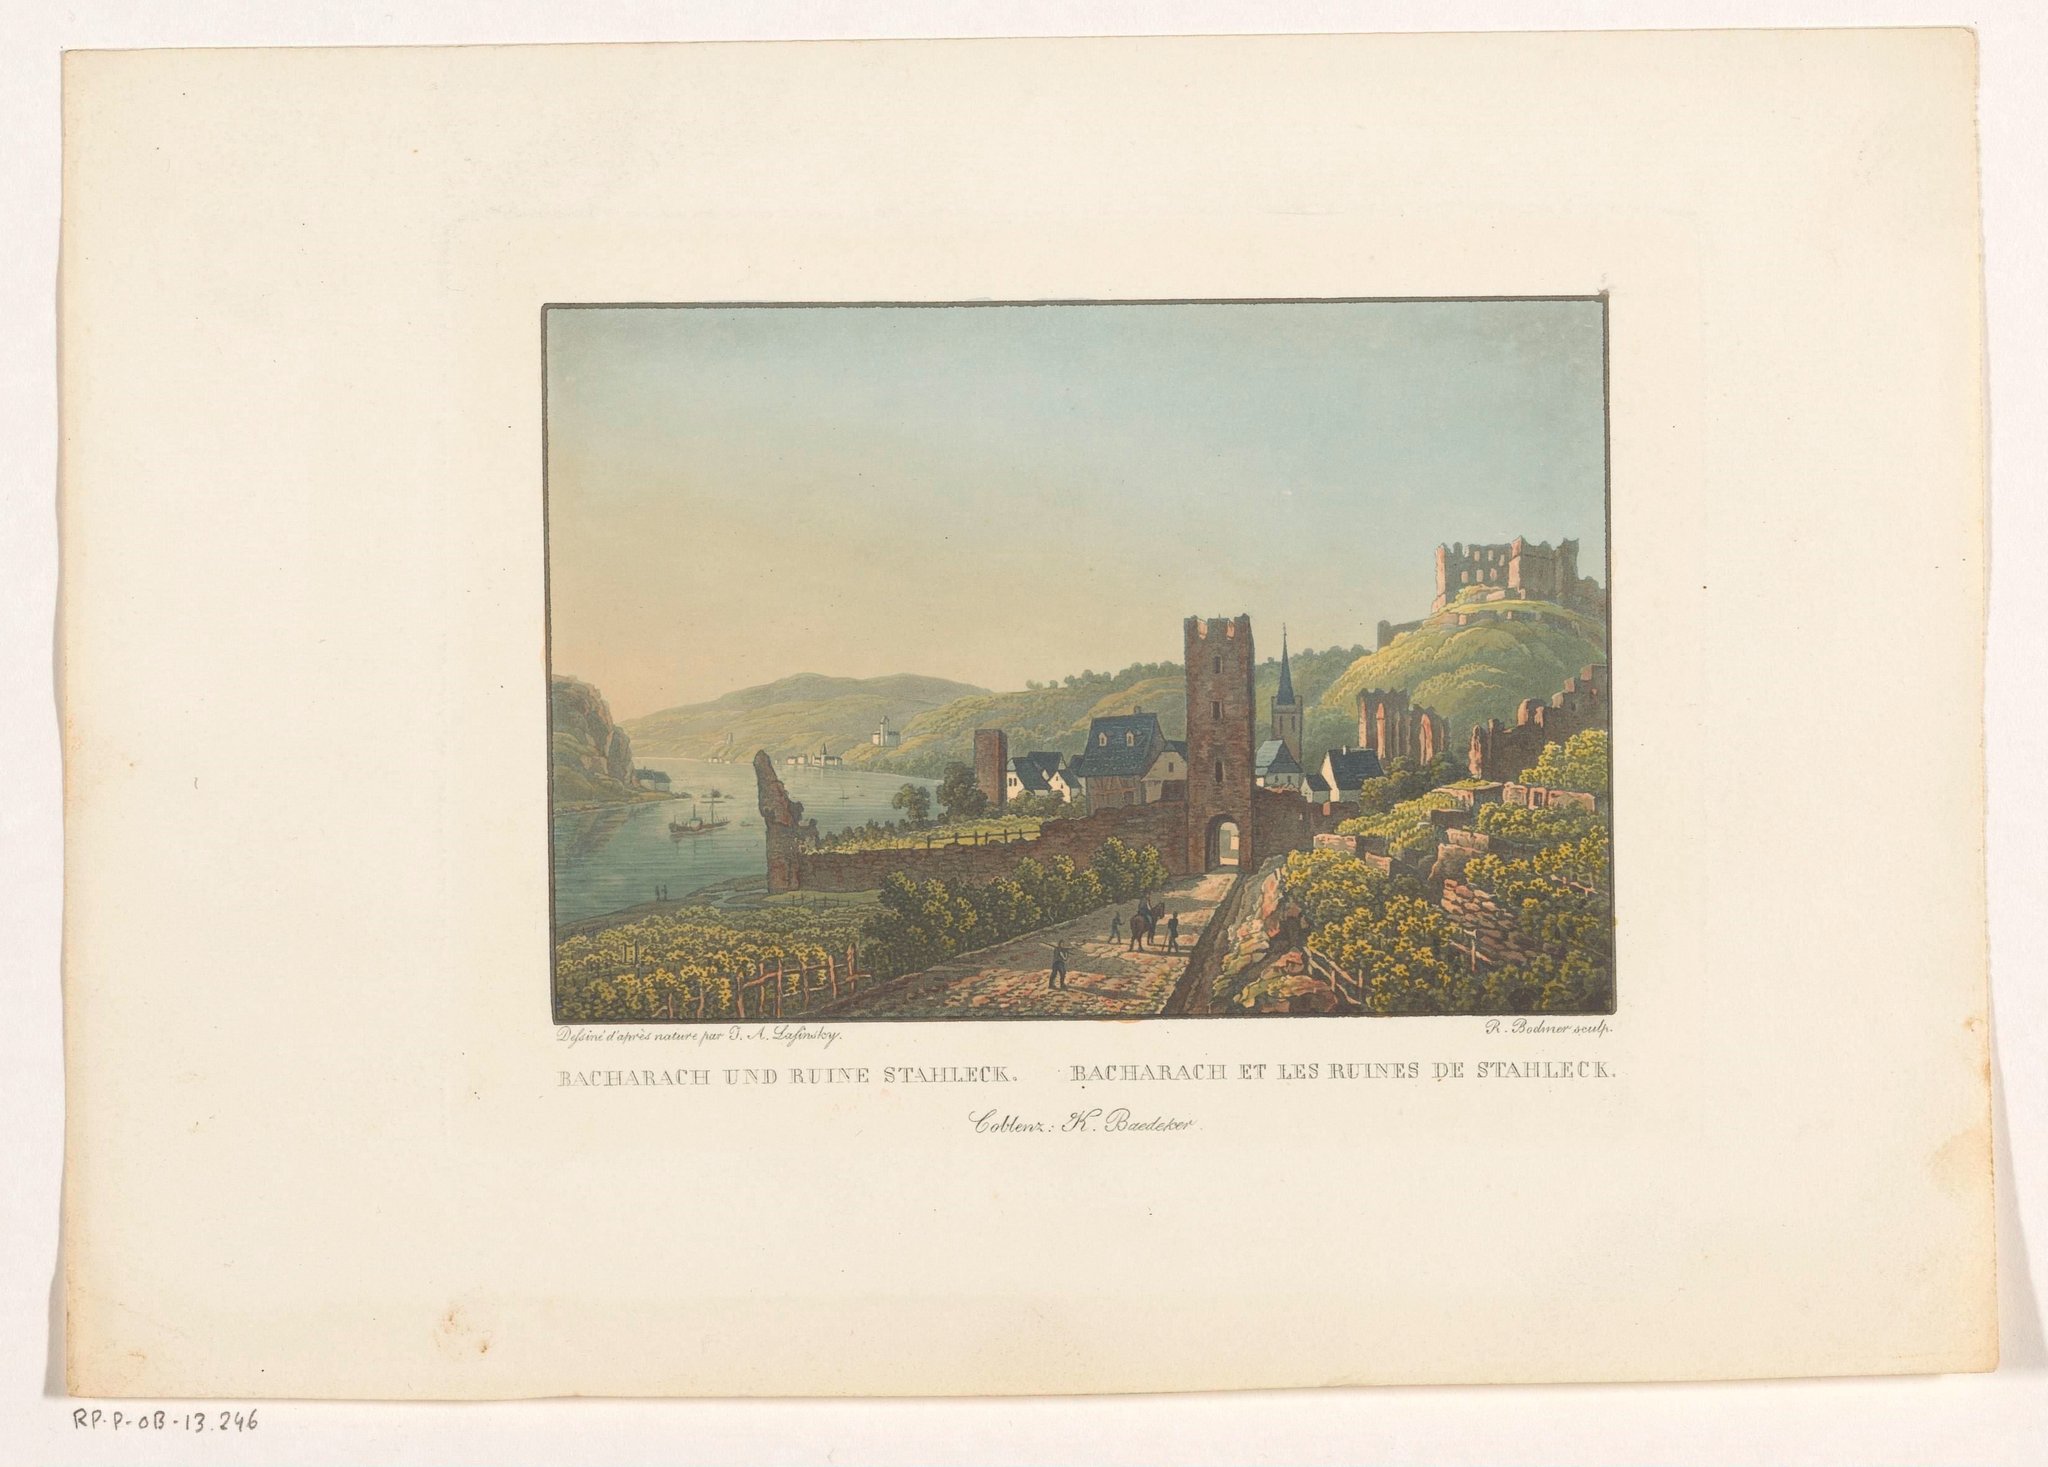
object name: print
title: Bacharach und Ruine Stahleck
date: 1832-1872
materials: paper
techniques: hand coloring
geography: koblenz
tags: river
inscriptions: collector's mark: Lugt 2228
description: Vanaf 1828 verschenen bij Franz Friedrich Röhling in Koblenz verschillende uitgaven met prenten van burchten en kastelen gelegen langs de Rijn, vervaardigd door Rudolf Bodmer naar tekeningen van Adolf Lasinsky. Vanaf 1832 verschenen deze publicaties bij Karl Baedeker, die het fonds van Röhling had overgenomen.